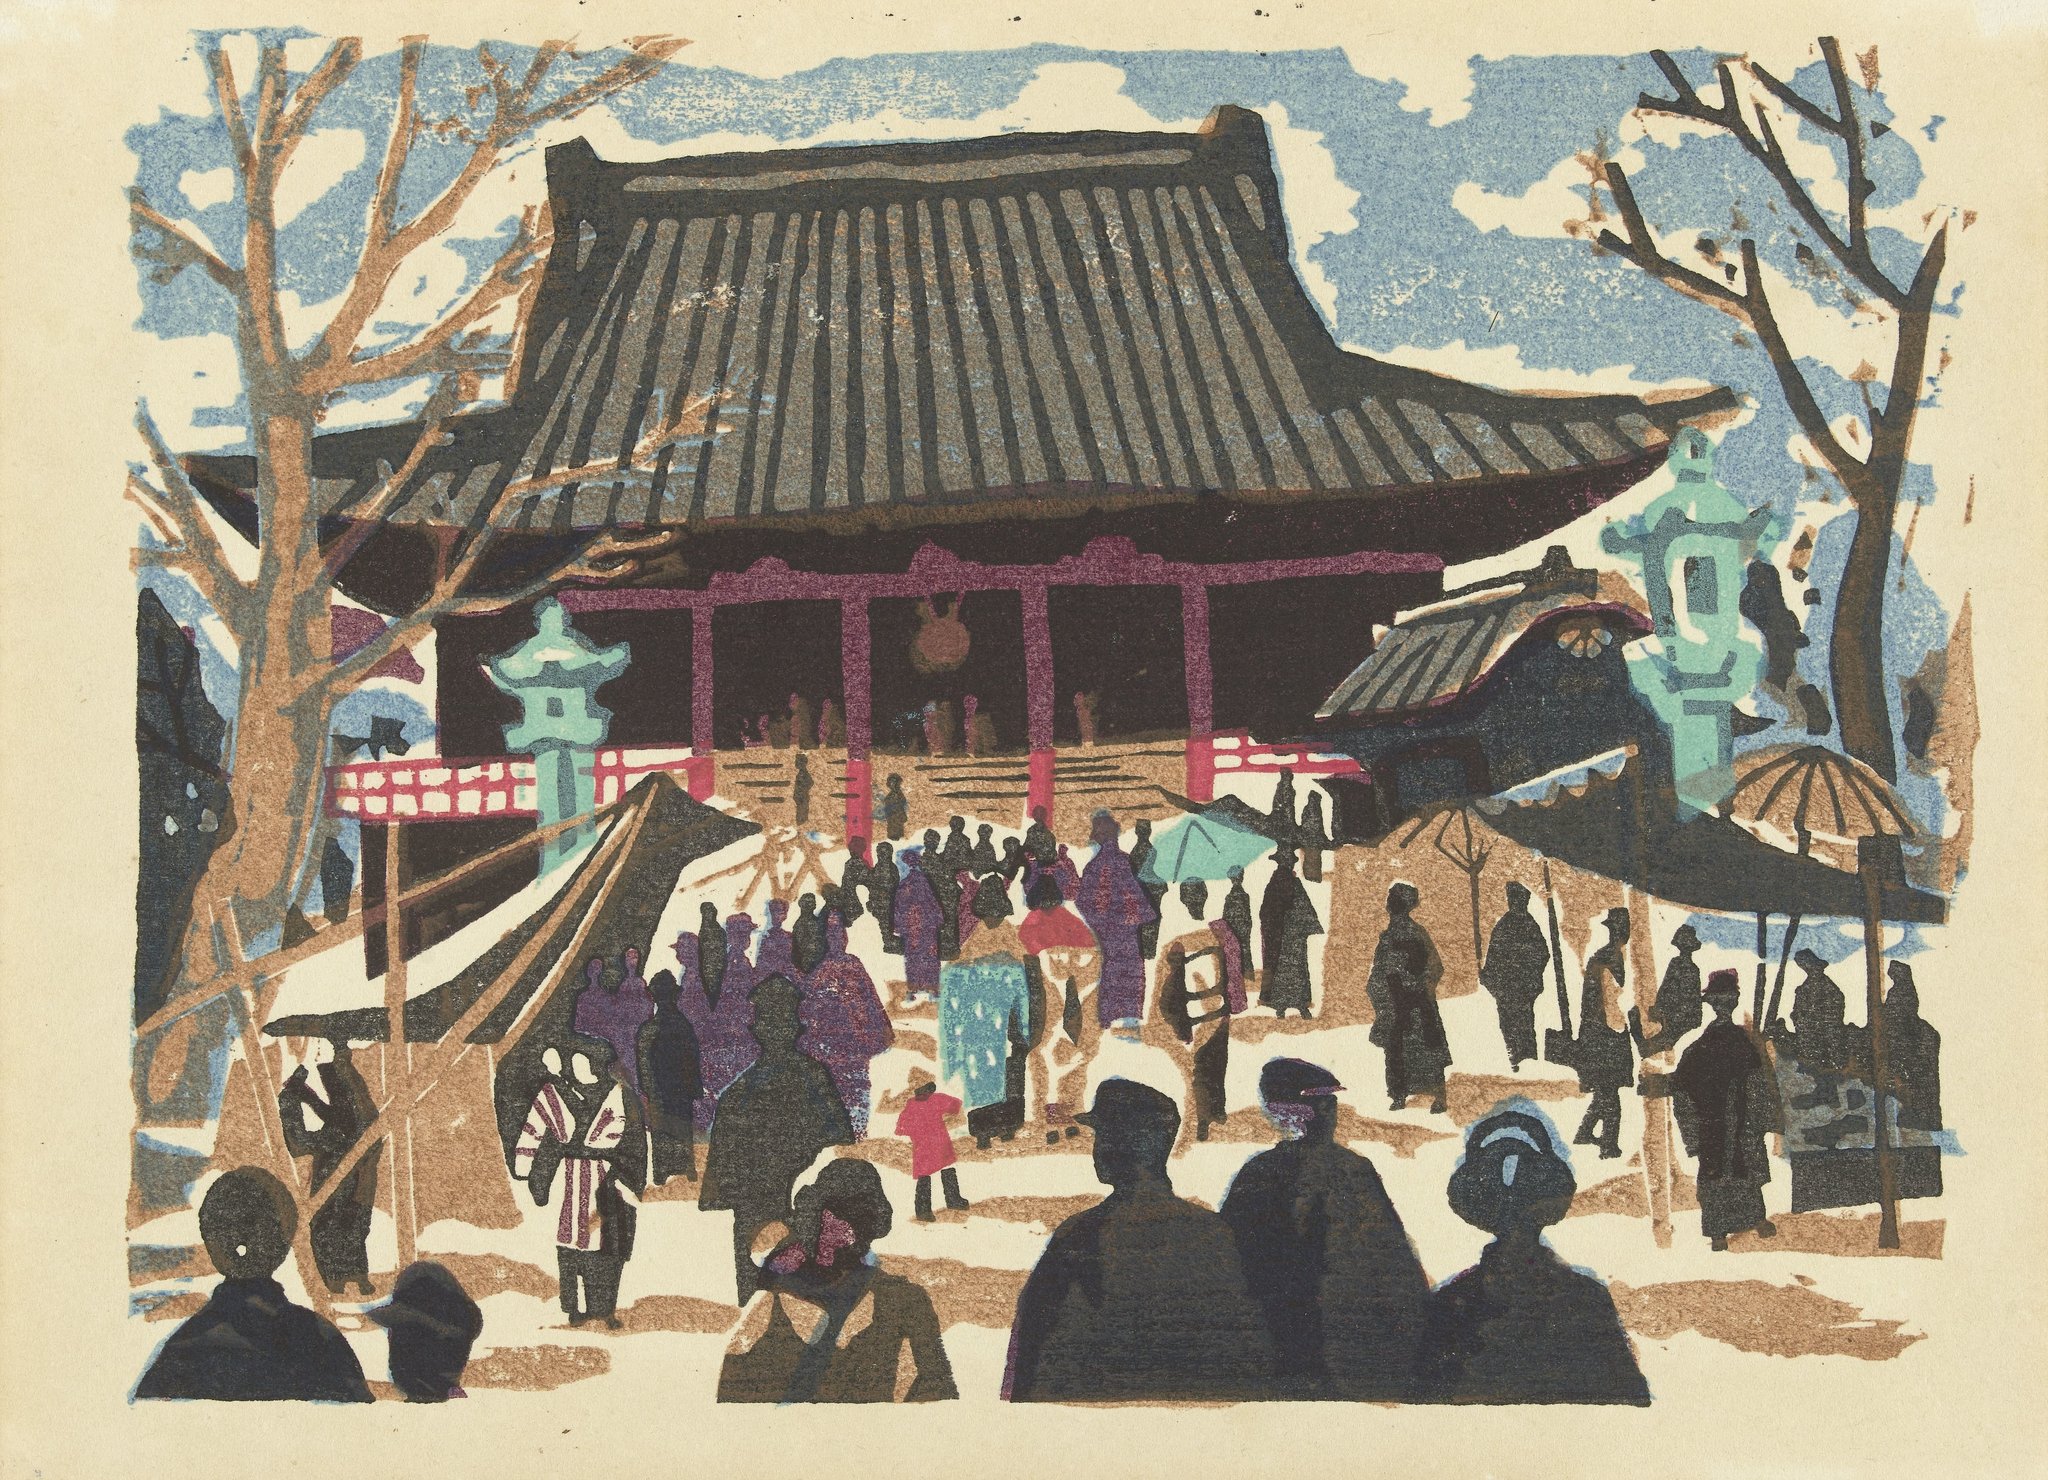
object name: print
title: Tokyo kaiko zue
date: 1912-1945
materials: paper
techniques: woodcut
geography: tokyo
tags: temple, shrine ~ hinduism, buddhism, jainism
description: Gezicht op bezoekers, lopend in de richting van tempel. In origineel passepartout met rechtsonder wit etiket waarop titel en naam van kunstenaar.